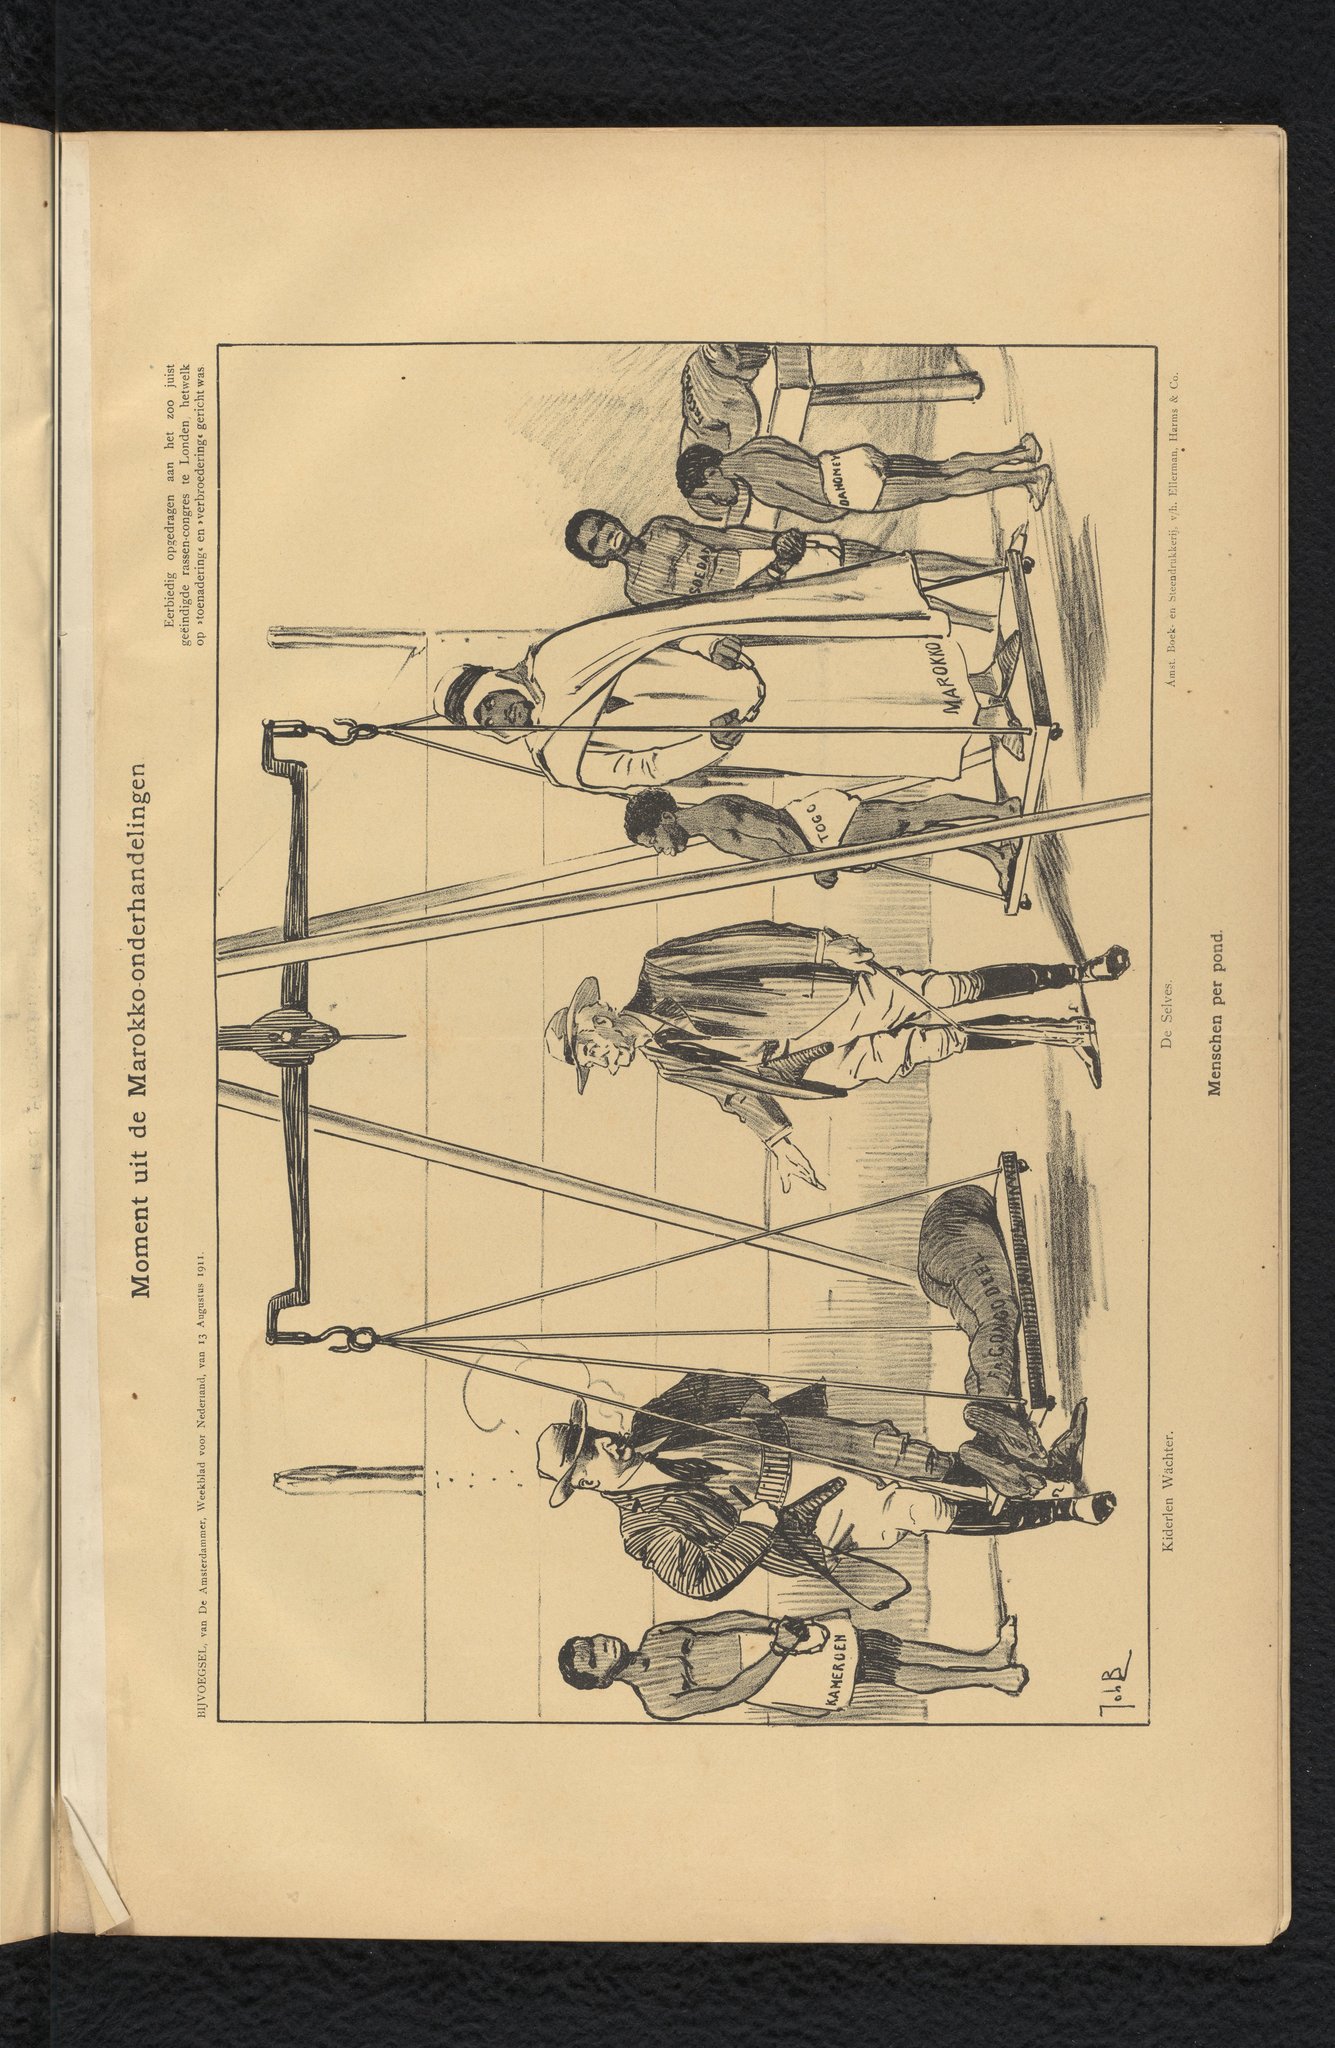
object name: cartoon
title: Moment uit de Marokko-onderhandelingen / Menschen per pond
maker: johan braakensiek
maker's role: draughtsman, print maker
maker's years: 1858-1940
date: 1911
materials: paper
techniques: lithograph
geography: amsterdam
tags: colonial system, imperialism, africans, scales, slavery; serfs and enslaved persons, political caricatures and satires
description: Duitse en Franse koloniale machten wegen Afrikaanse landen en landsdelen op een weegschaal. De Afrikaanse landen zijn voorgesteld als geketende mensen. Frans Congo is in twee stukken verdeeld, één deel ligt op de weegschaal.